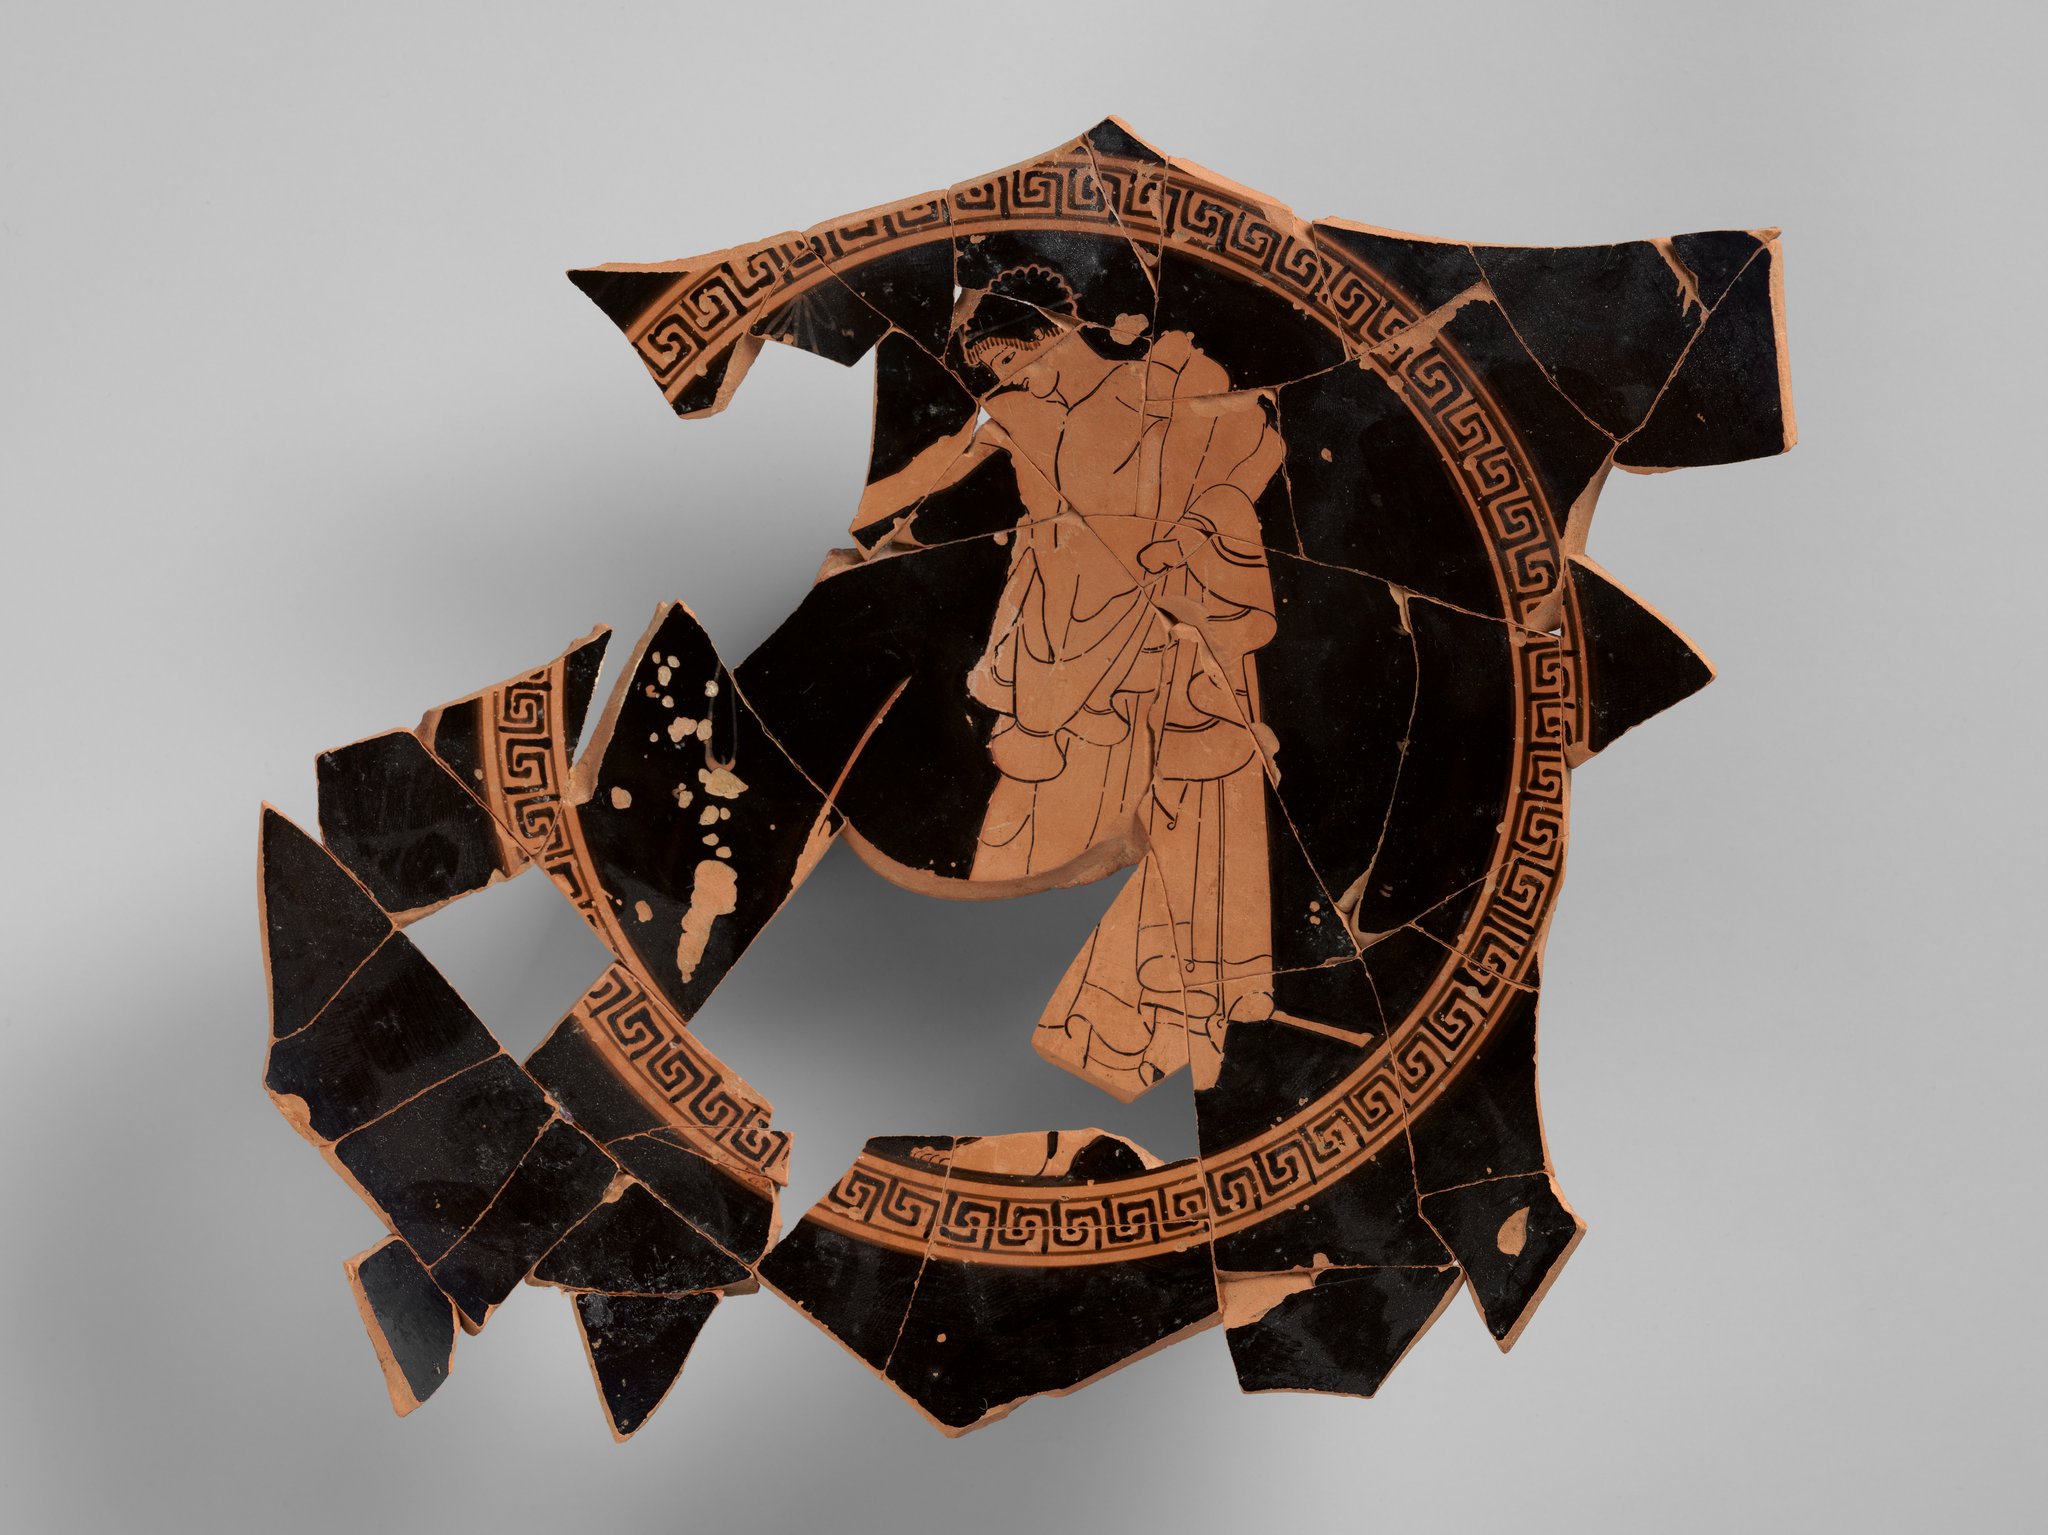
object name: kylix fragment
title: Kylix Fragments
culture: greek, attic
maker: antiphon painter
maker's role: artist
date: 480 BCE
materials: terracotta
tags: men